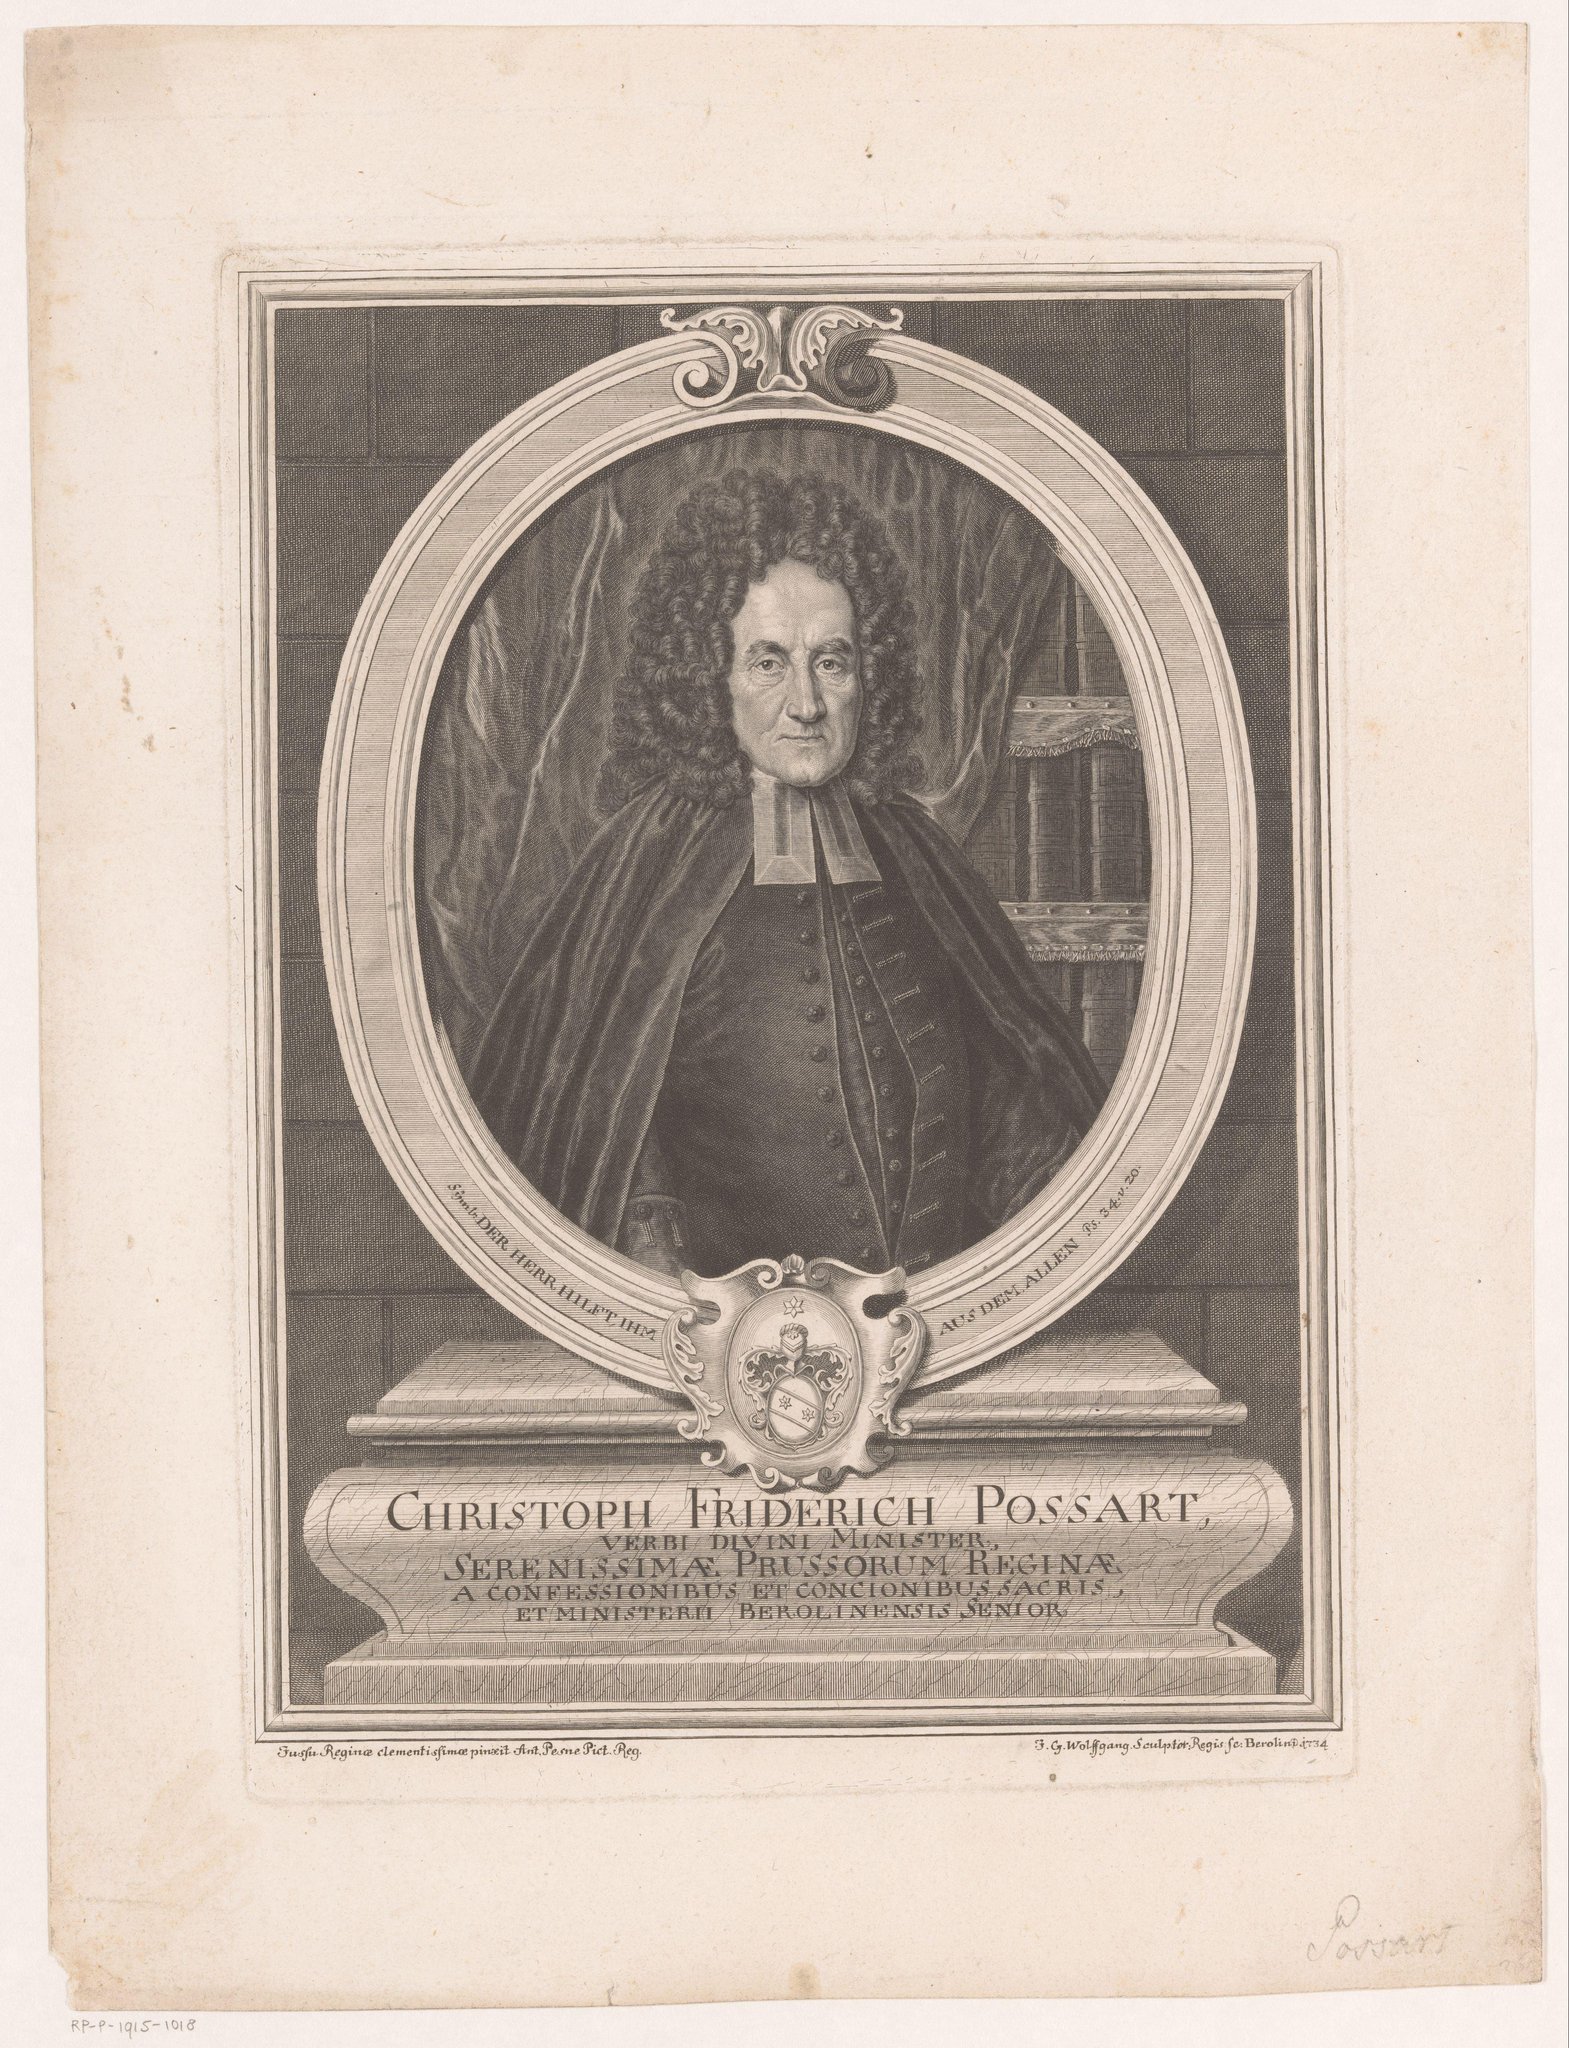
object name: print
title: Portret van Christoph Friedrich Possardt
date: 1734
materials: paper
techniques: engraving, etching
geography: berlin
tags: bookshelves, historical persons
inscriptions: collector's mark: Lugt 2228